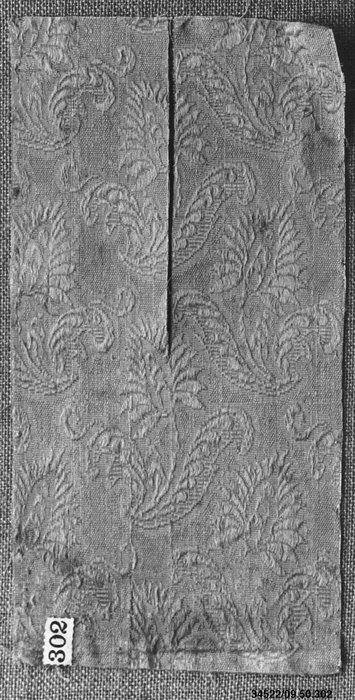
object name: piece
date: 1701-1800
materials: silk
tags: flowers,leaves